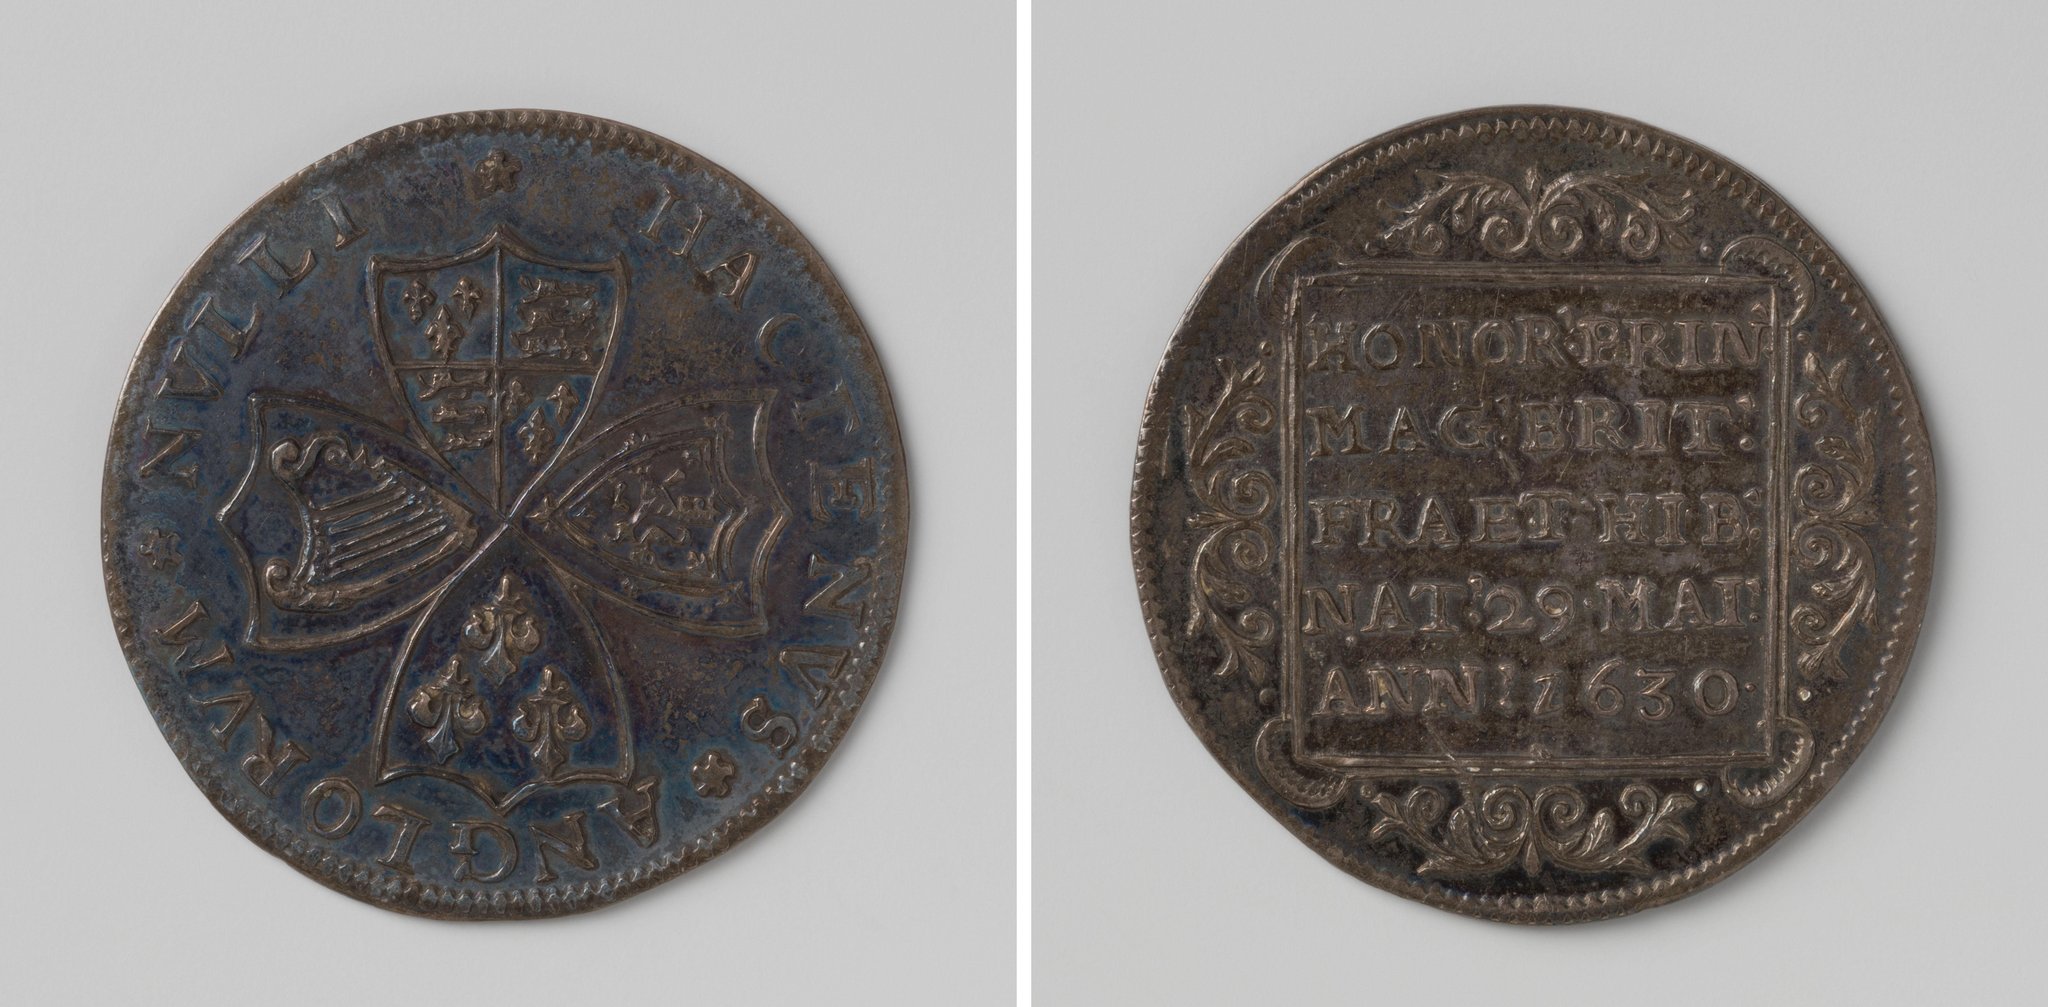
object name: jeton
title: Geboorte van Karel, erfprins van Engeland, Schotland, Ierland en Frankrijk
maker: Anonymous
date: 1630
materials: silver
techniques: striking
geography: netherlands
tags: london, karel ii (koning van engeland)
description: Zilveren penning. Voorzijde: vier in kruis geplaatste, hartvormige wapenschilden binnen omschrift. Keerzijde: tableau met opschrift, omgeven door siermotief